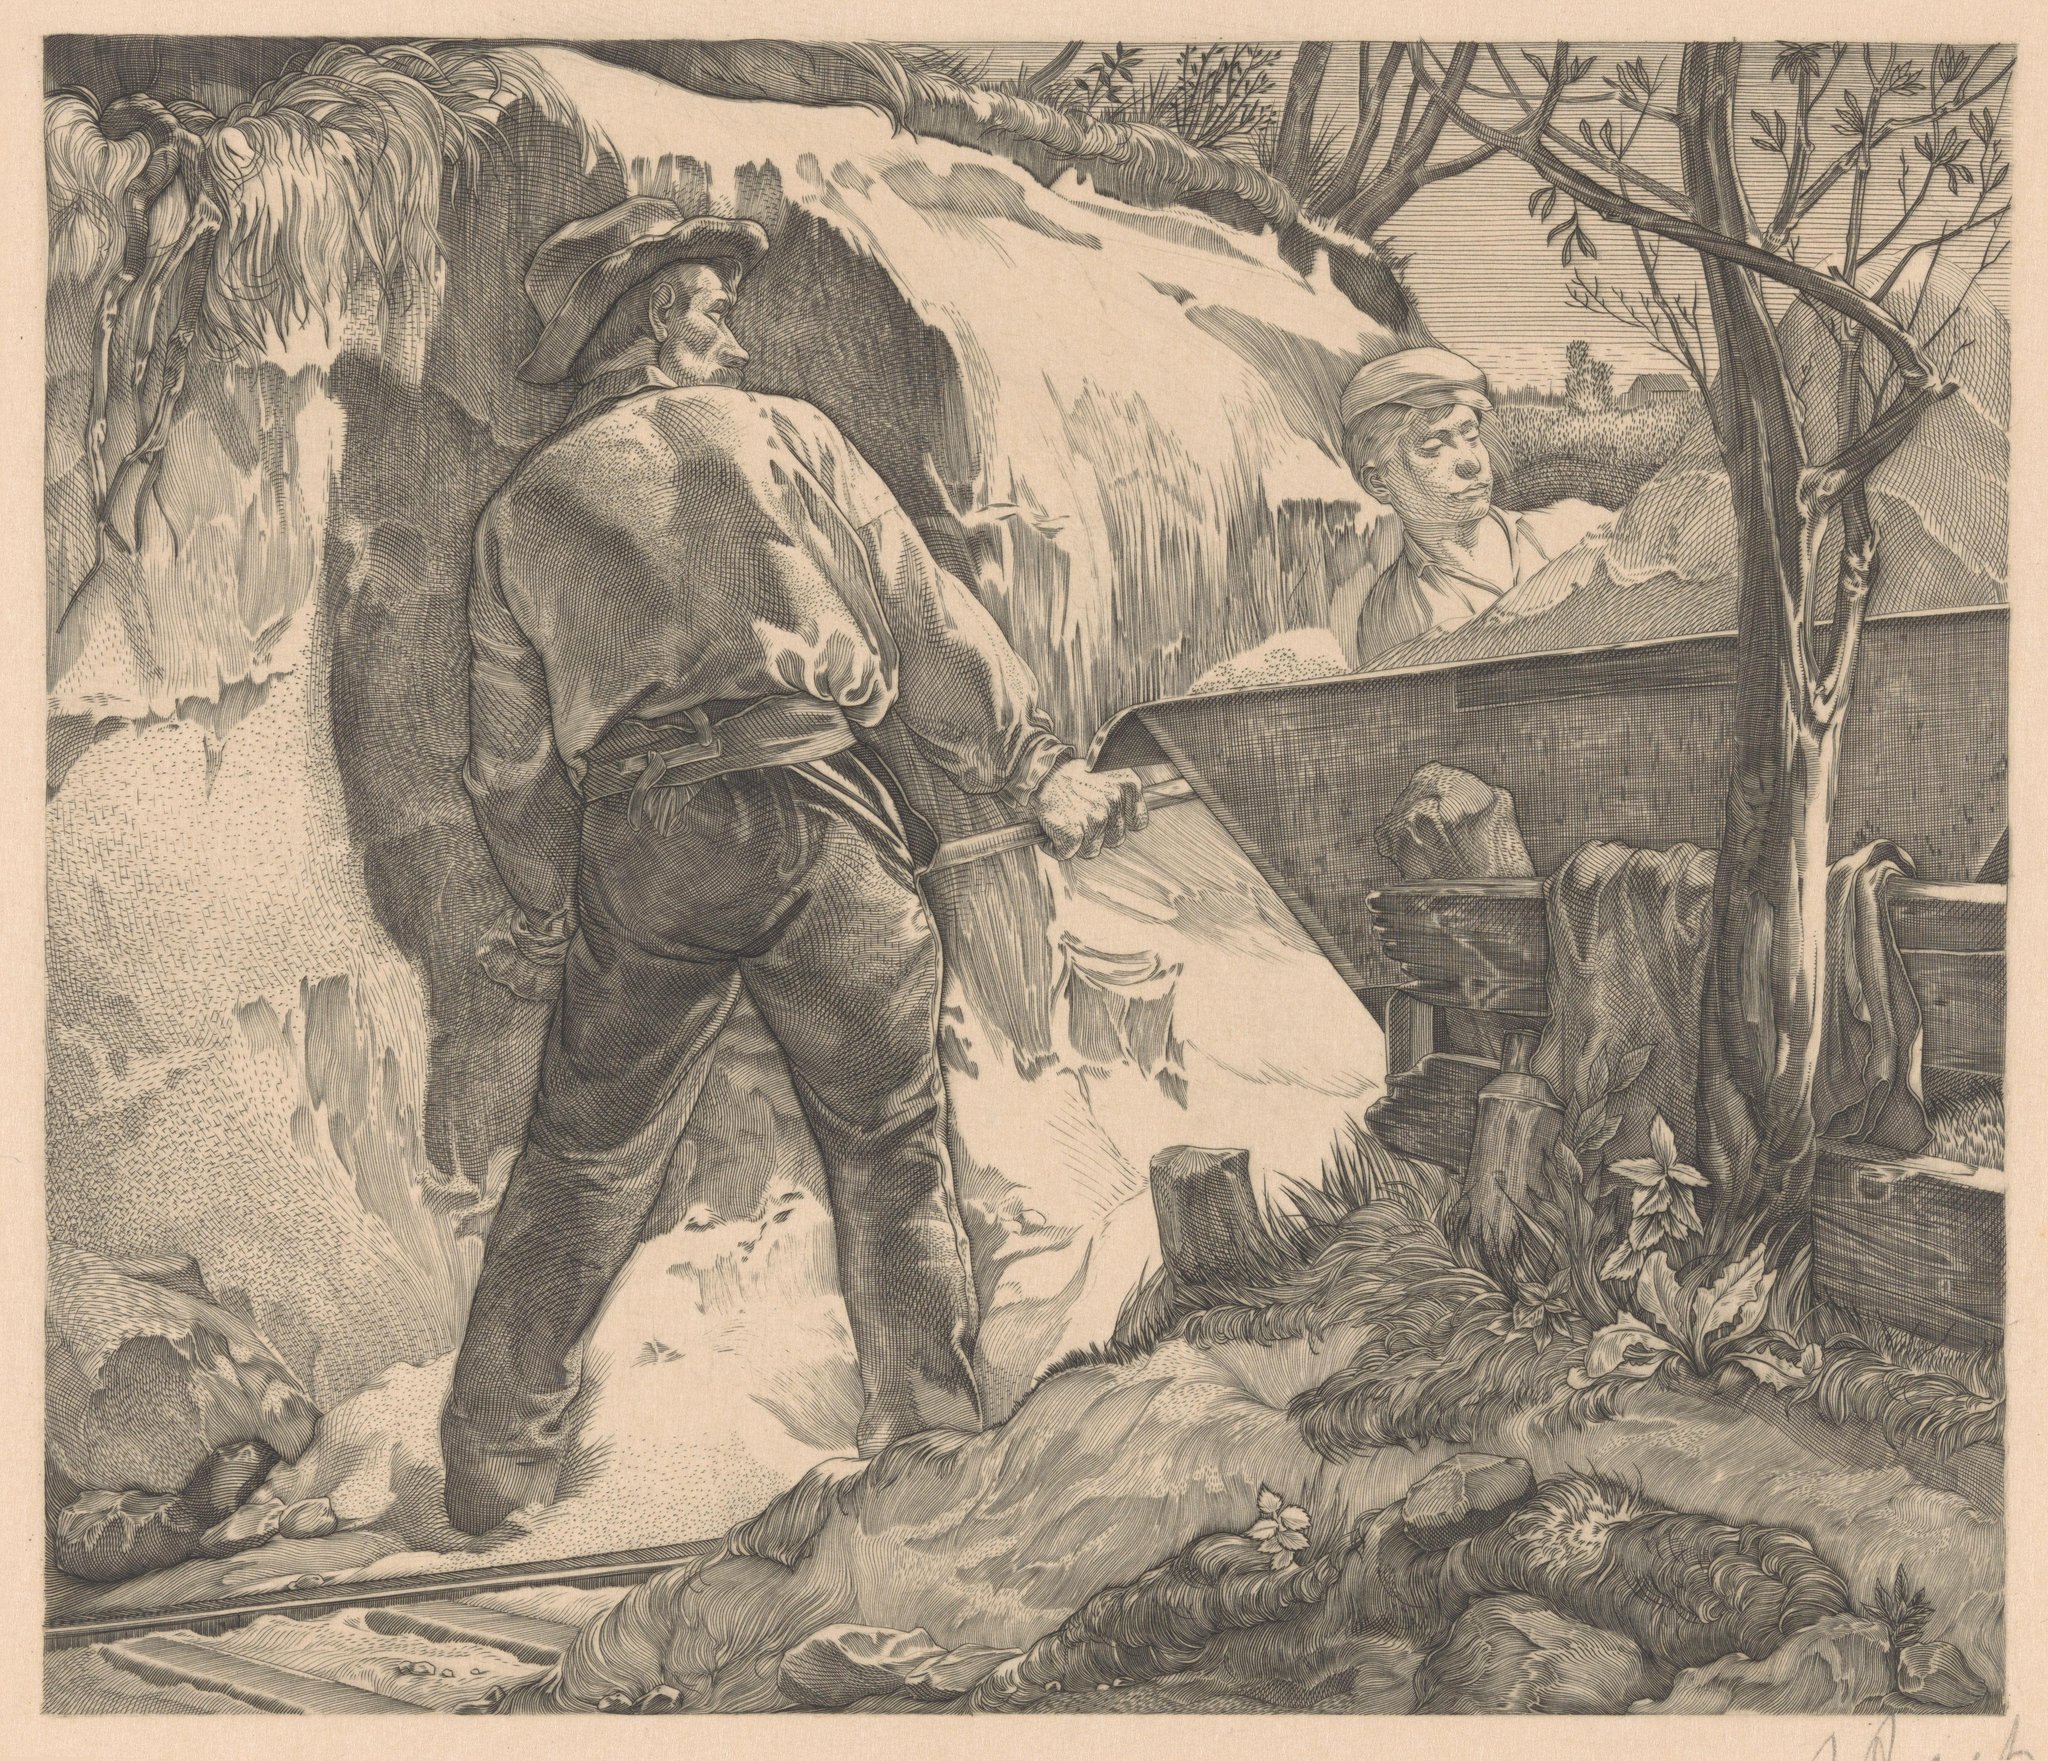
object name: print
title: Zandgravers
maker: johannes josephus aarts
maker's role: draughtsman, print maker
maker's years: 1871-1934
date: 1881-1931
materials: paper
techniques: engraving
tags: sand (soil type), working class, labourers, digging (industrial process)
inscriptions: collector's mark: Lugt 2228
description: Twee mannen graven een zandheuvel af en vullen er een kar met zand mee.